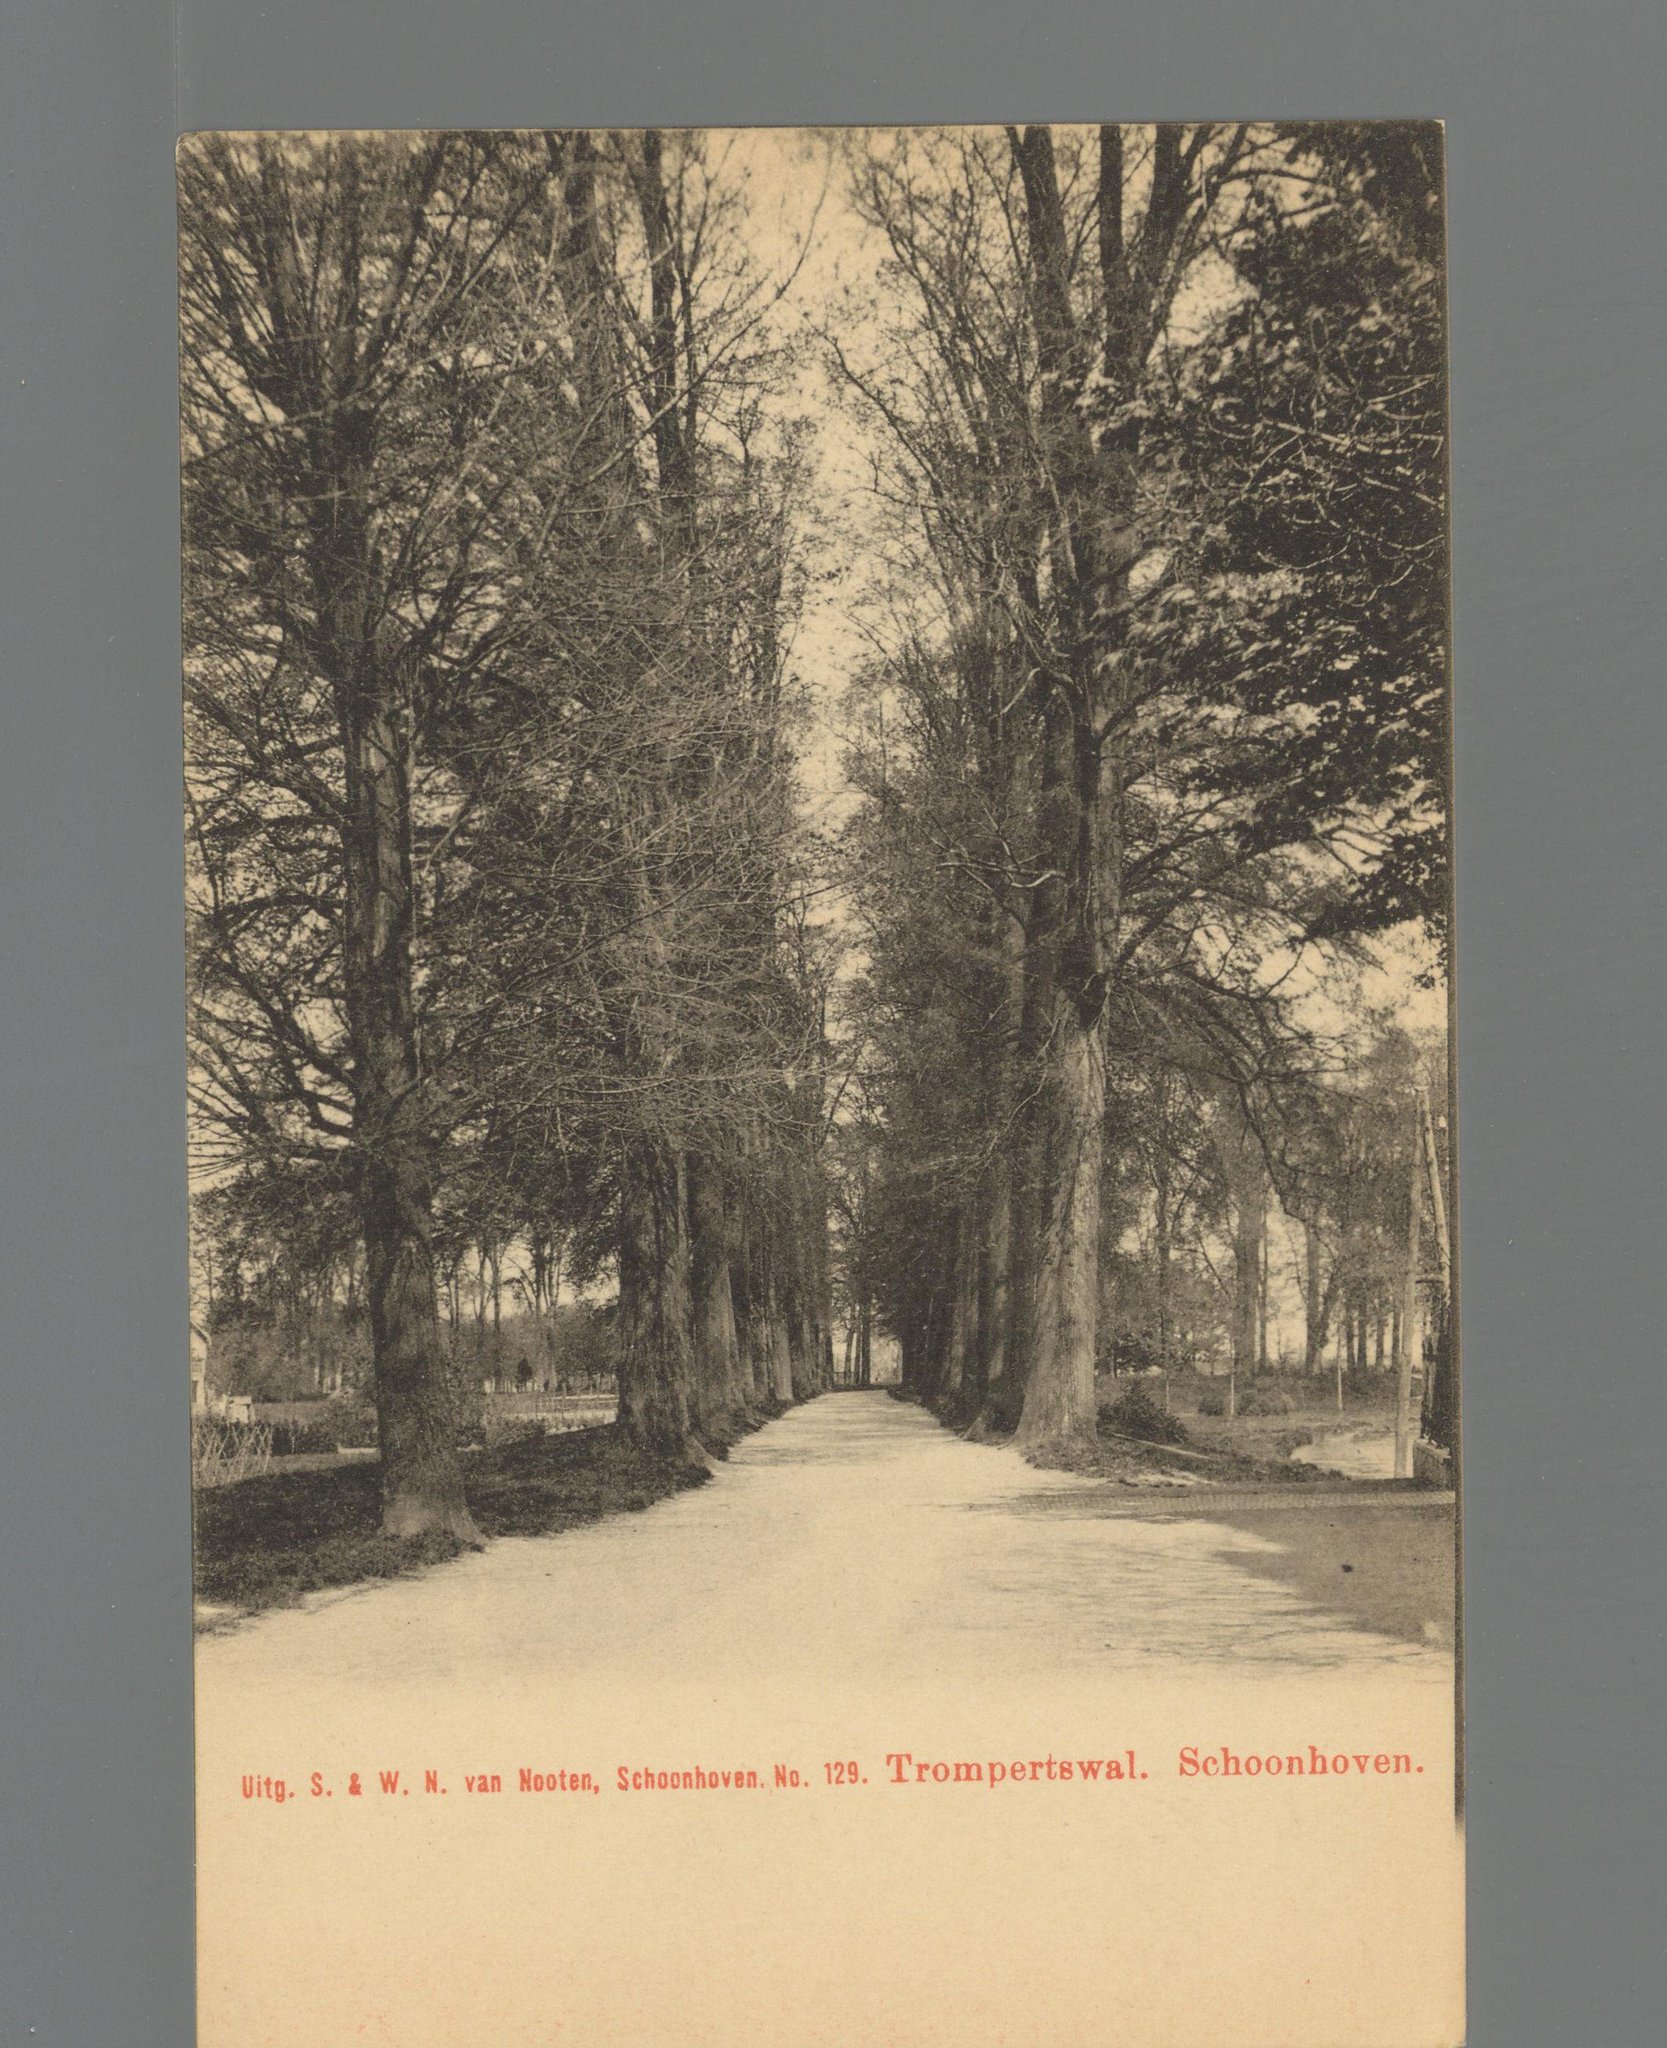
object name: ansichtkaart, prentbriefkaart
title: Trompertswal. Schoonhoven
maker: Anonymous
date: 1897-1905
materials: cardboard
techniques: photograph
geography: schoonhoven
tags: park, road, path